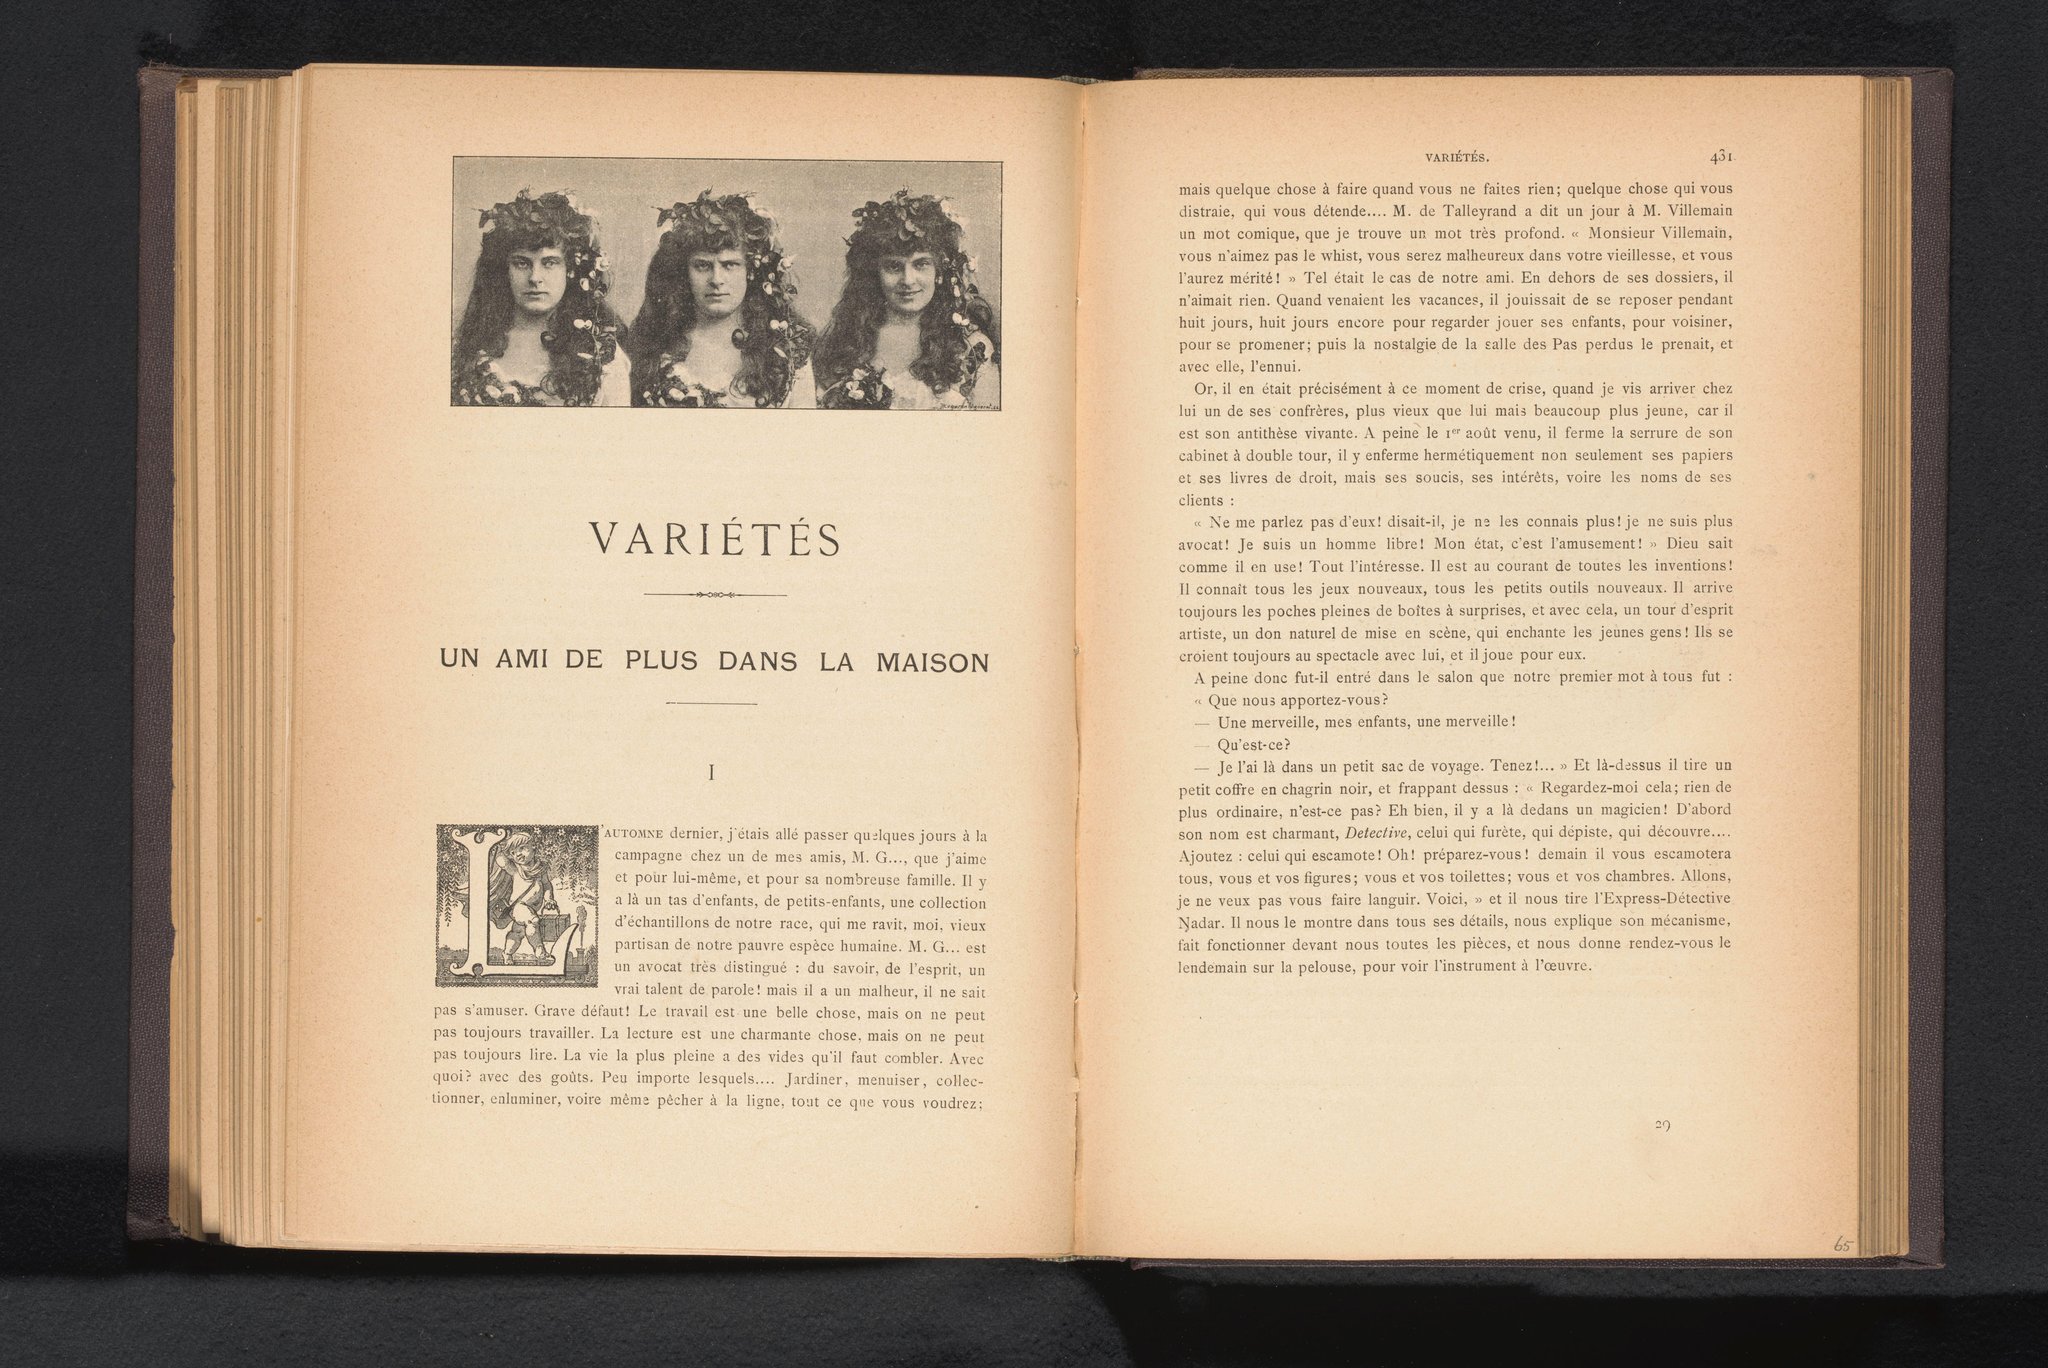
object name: page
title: Drie portretten van een onbekende vrouw die verschillende emoties toont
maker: Anonymous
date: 1883-1893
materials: paper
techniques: autotype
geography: france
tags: passions, emotions, affections, adult woman